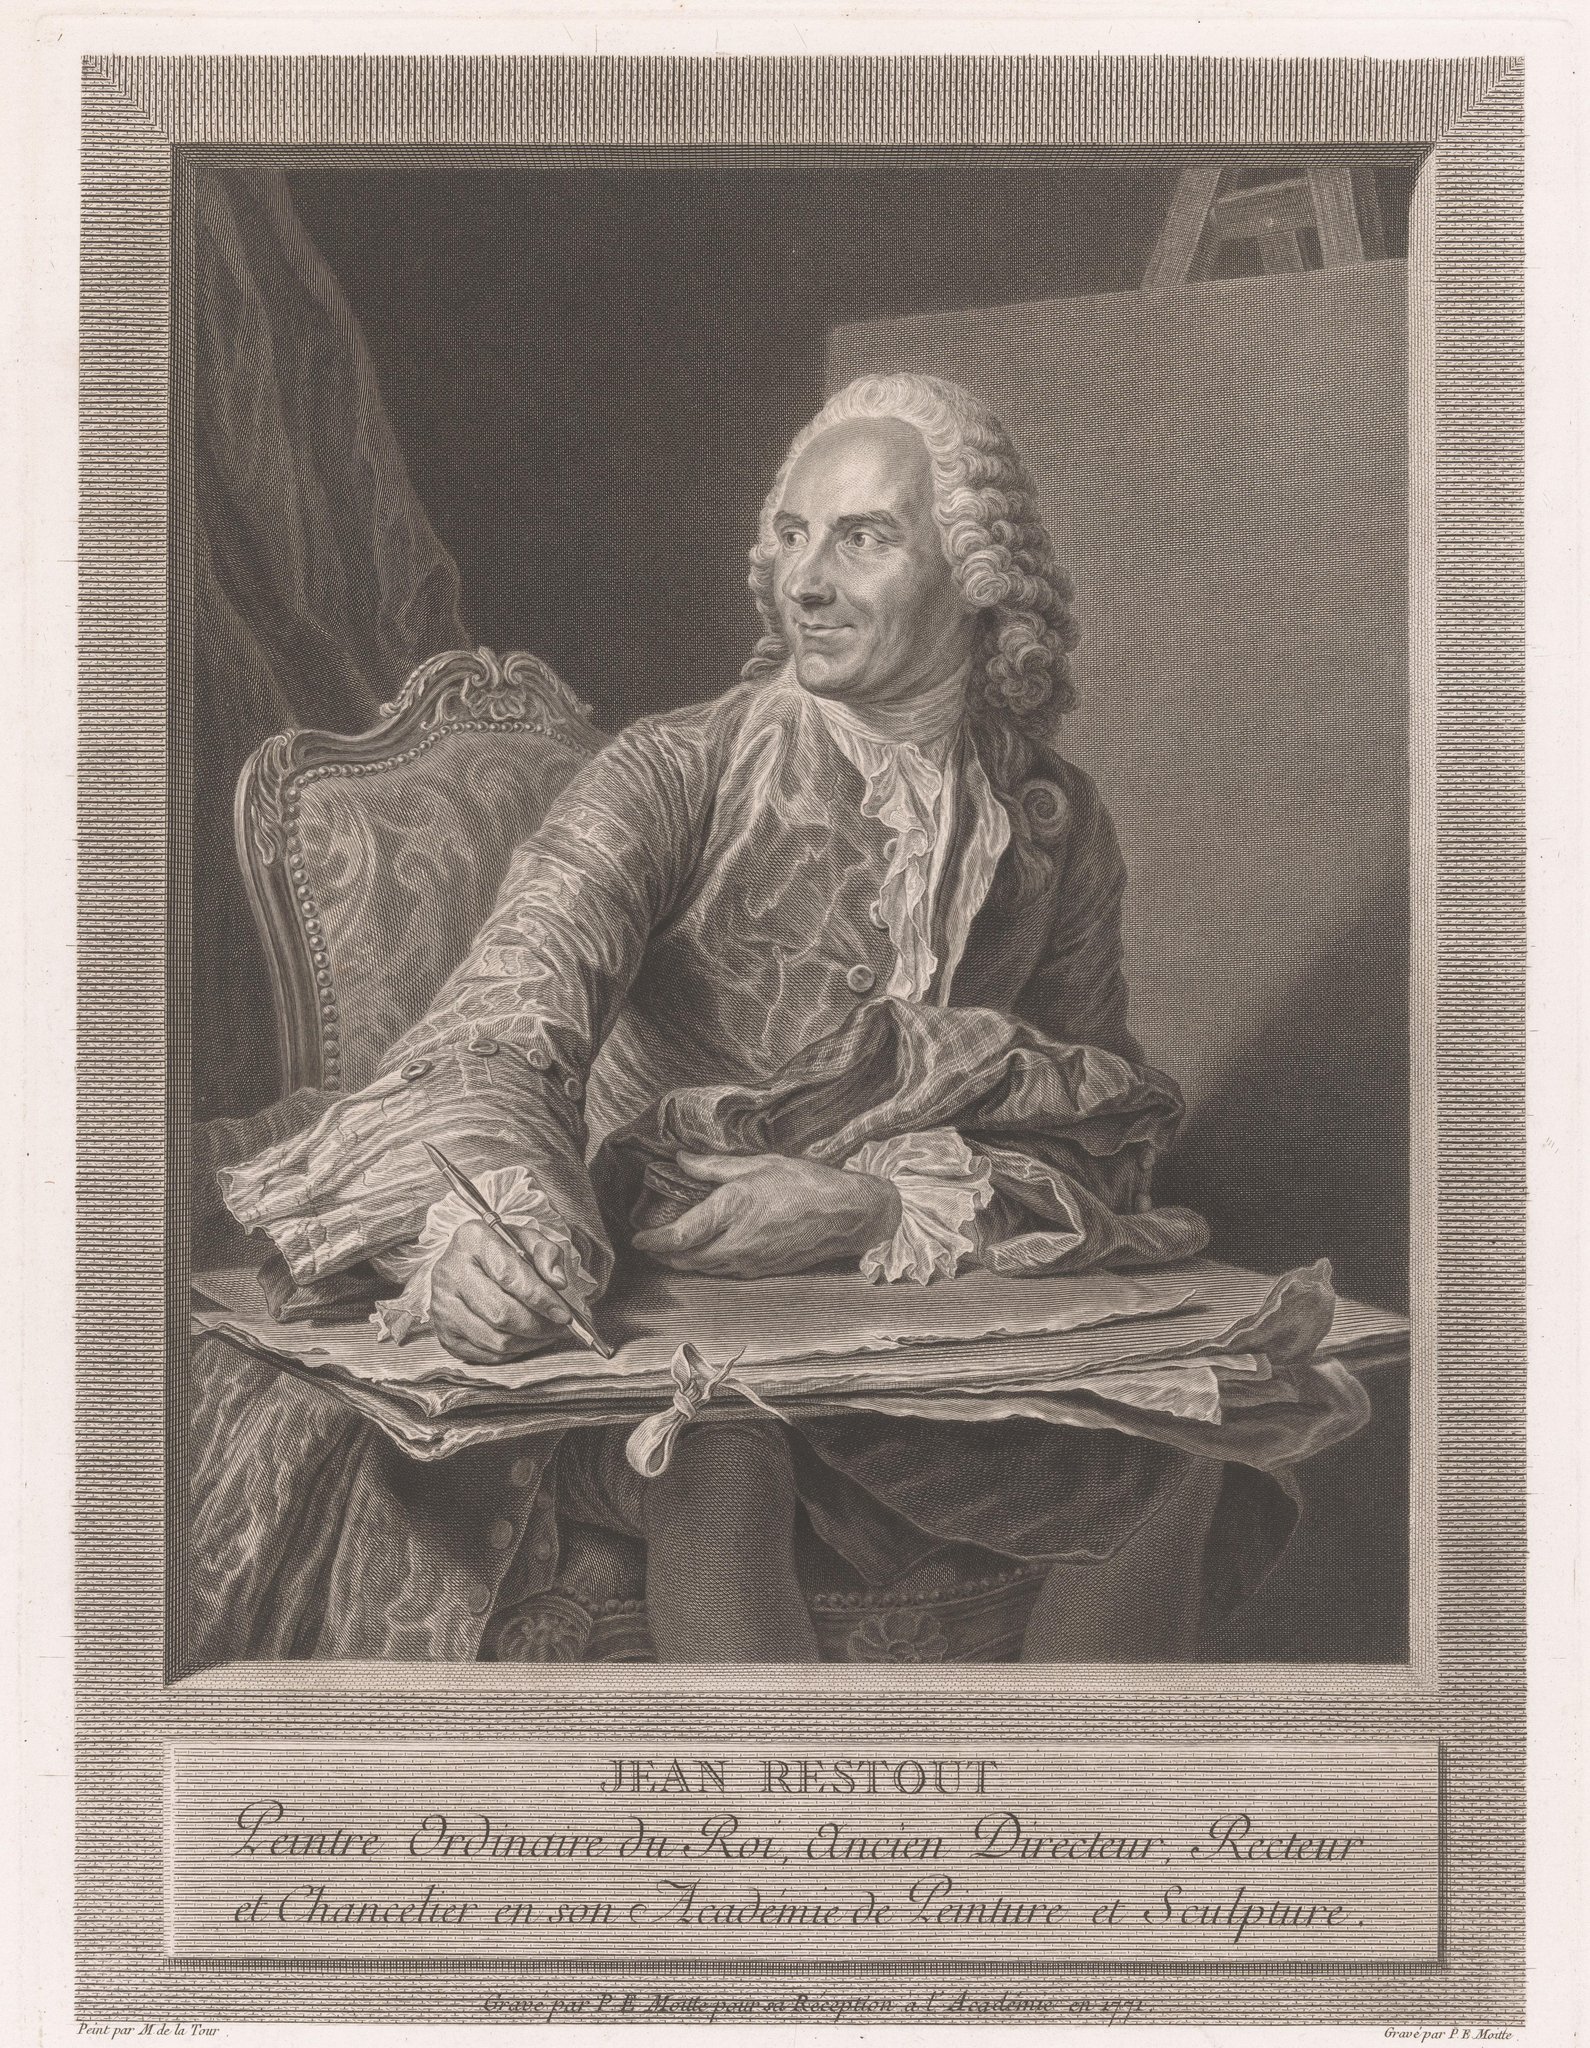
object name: print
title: Portret van Jean Restout (II)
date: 1771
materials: paper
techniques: engraving, etching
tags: paris, draughtsman, jean restout (ii), historical persons, draughtsman at work, portrait, self-portrait of artist, tools, implements of draughtsman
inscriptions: collector's mark: Lugt 2233, number: ‘B 56’